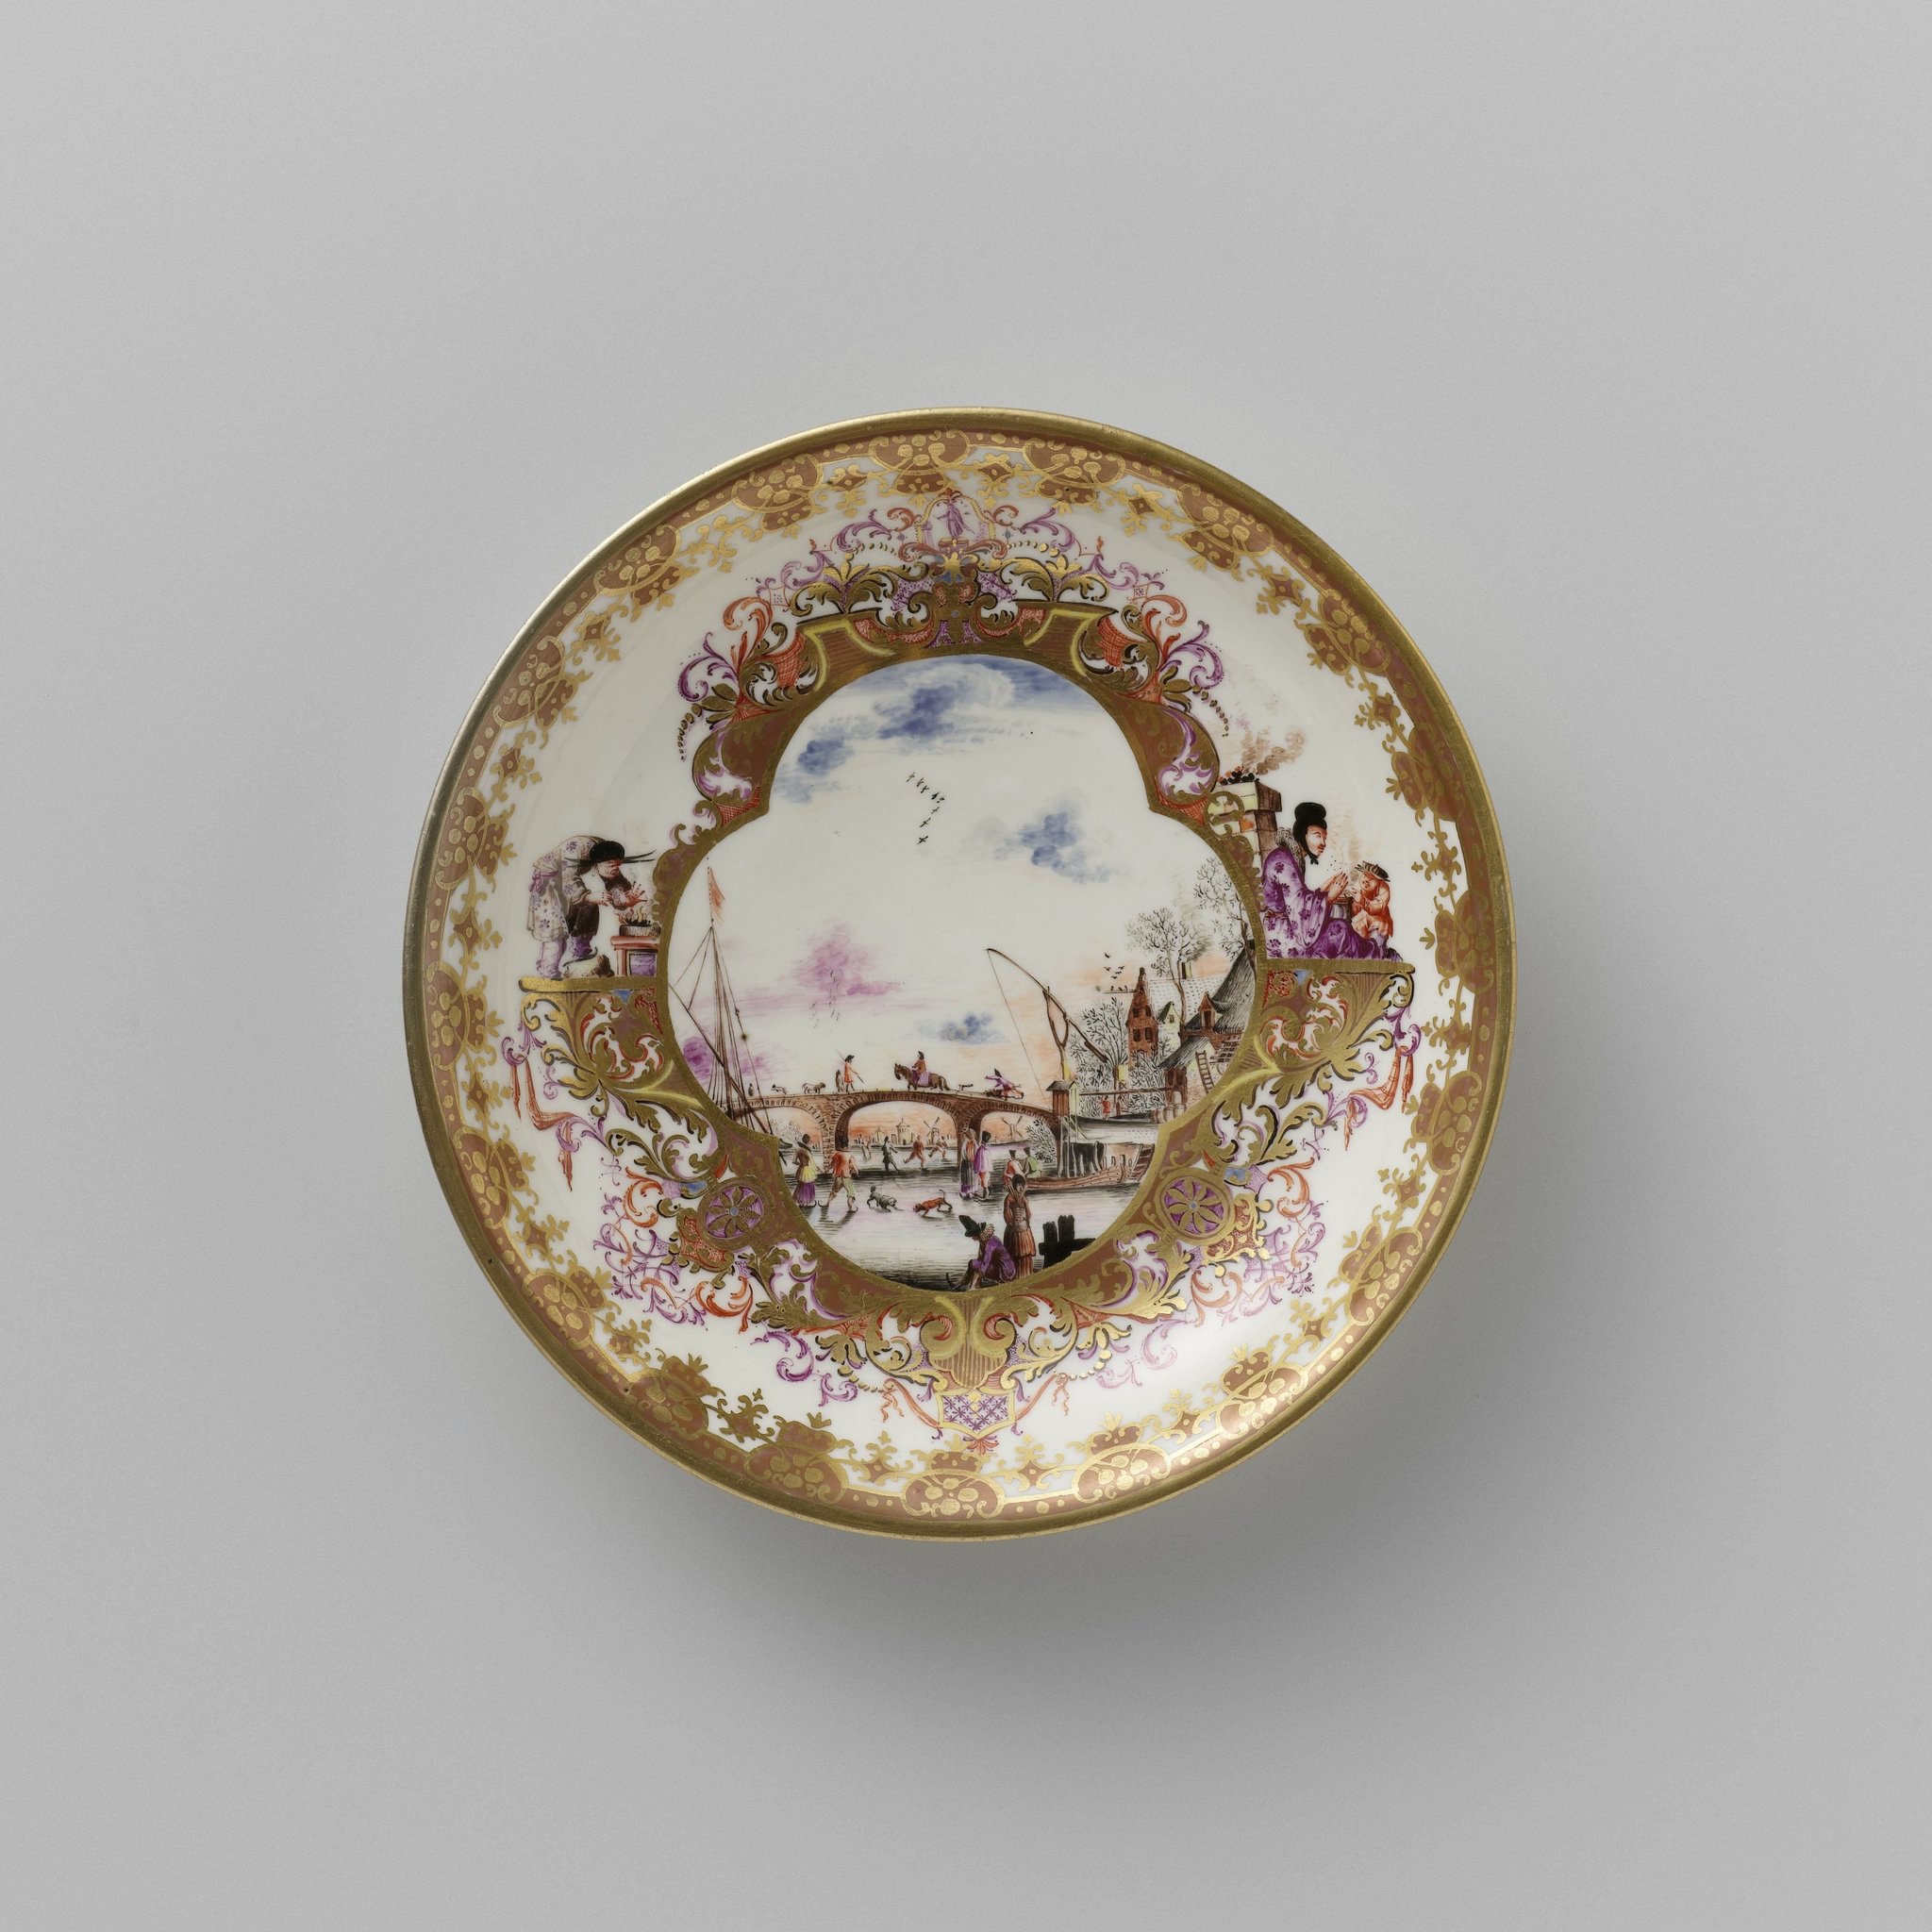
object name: plate dish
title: Bord, veelkleurig beschilderd met een winterlandschap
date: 1730-1735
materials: porcelain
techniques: painted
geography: meissen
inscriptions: factory mark, label: ‘SAMMLUNG / Dr. FRANZ OPPENHEIMER’, number: ‘214.’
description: Plate. Porcelain. Meissen, c. 1730 - 1735. The winter landscape after a print of 1616 by Jan van de Velde.